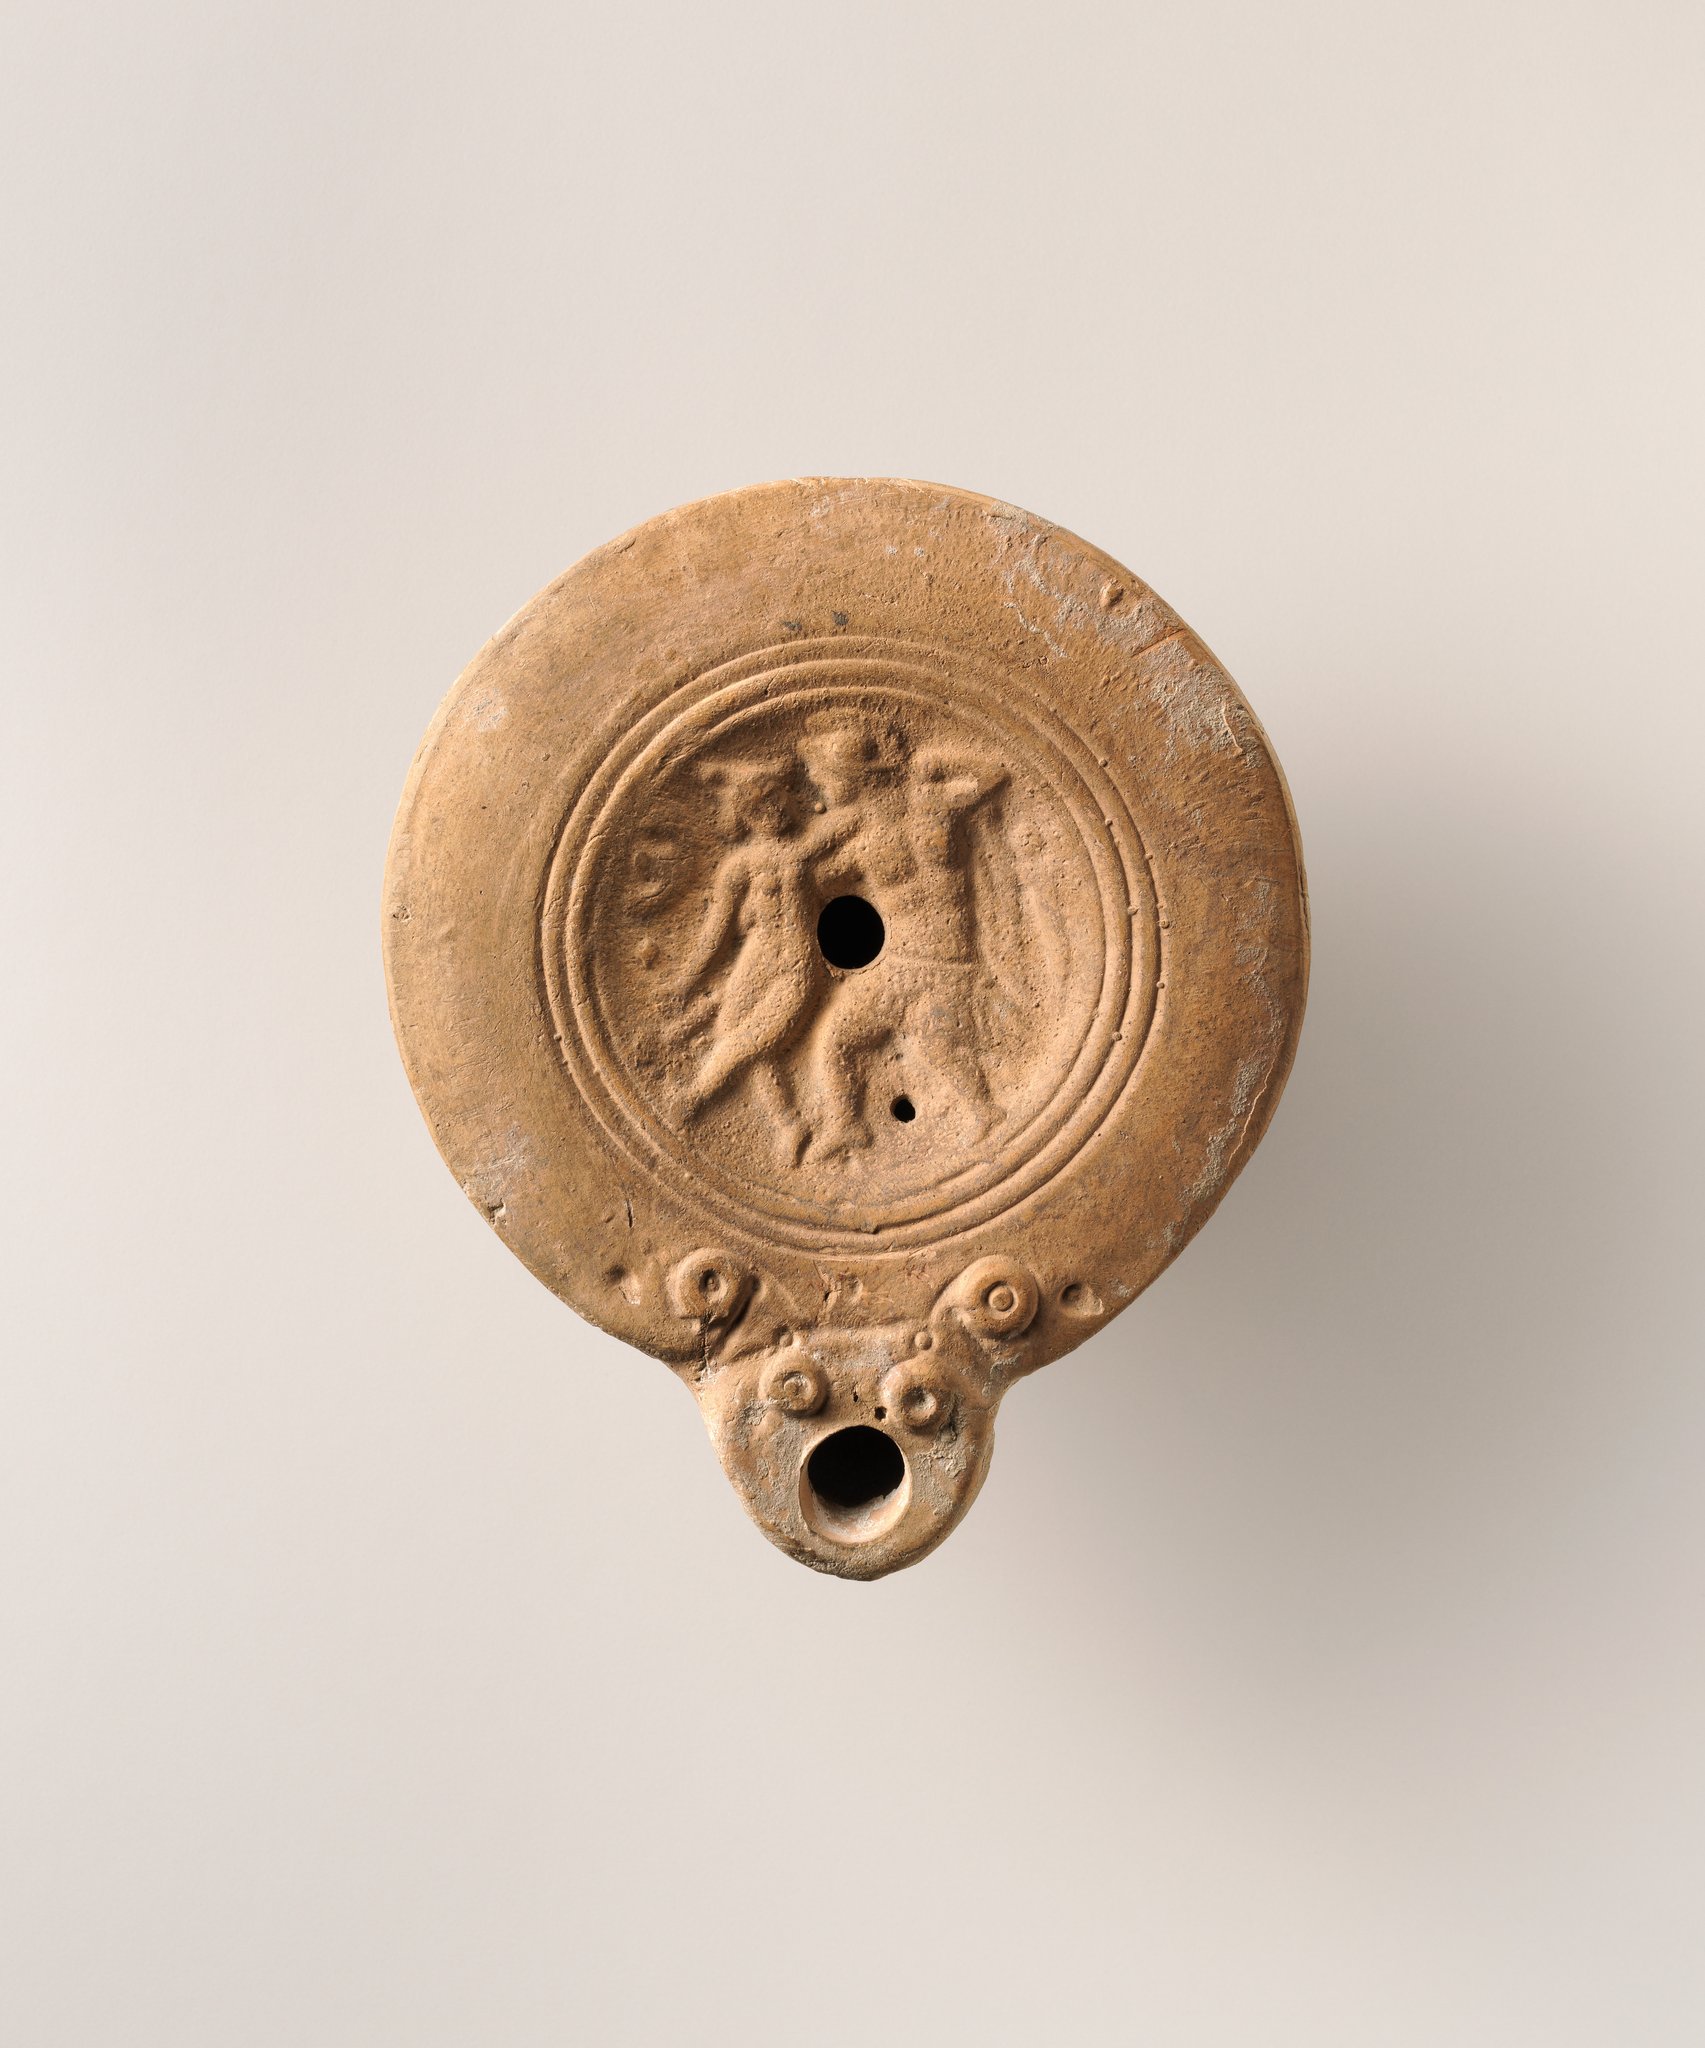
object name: lamp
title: Terracotta oil lamp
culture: roman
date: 101-200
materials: terracotta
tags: women,gladiators